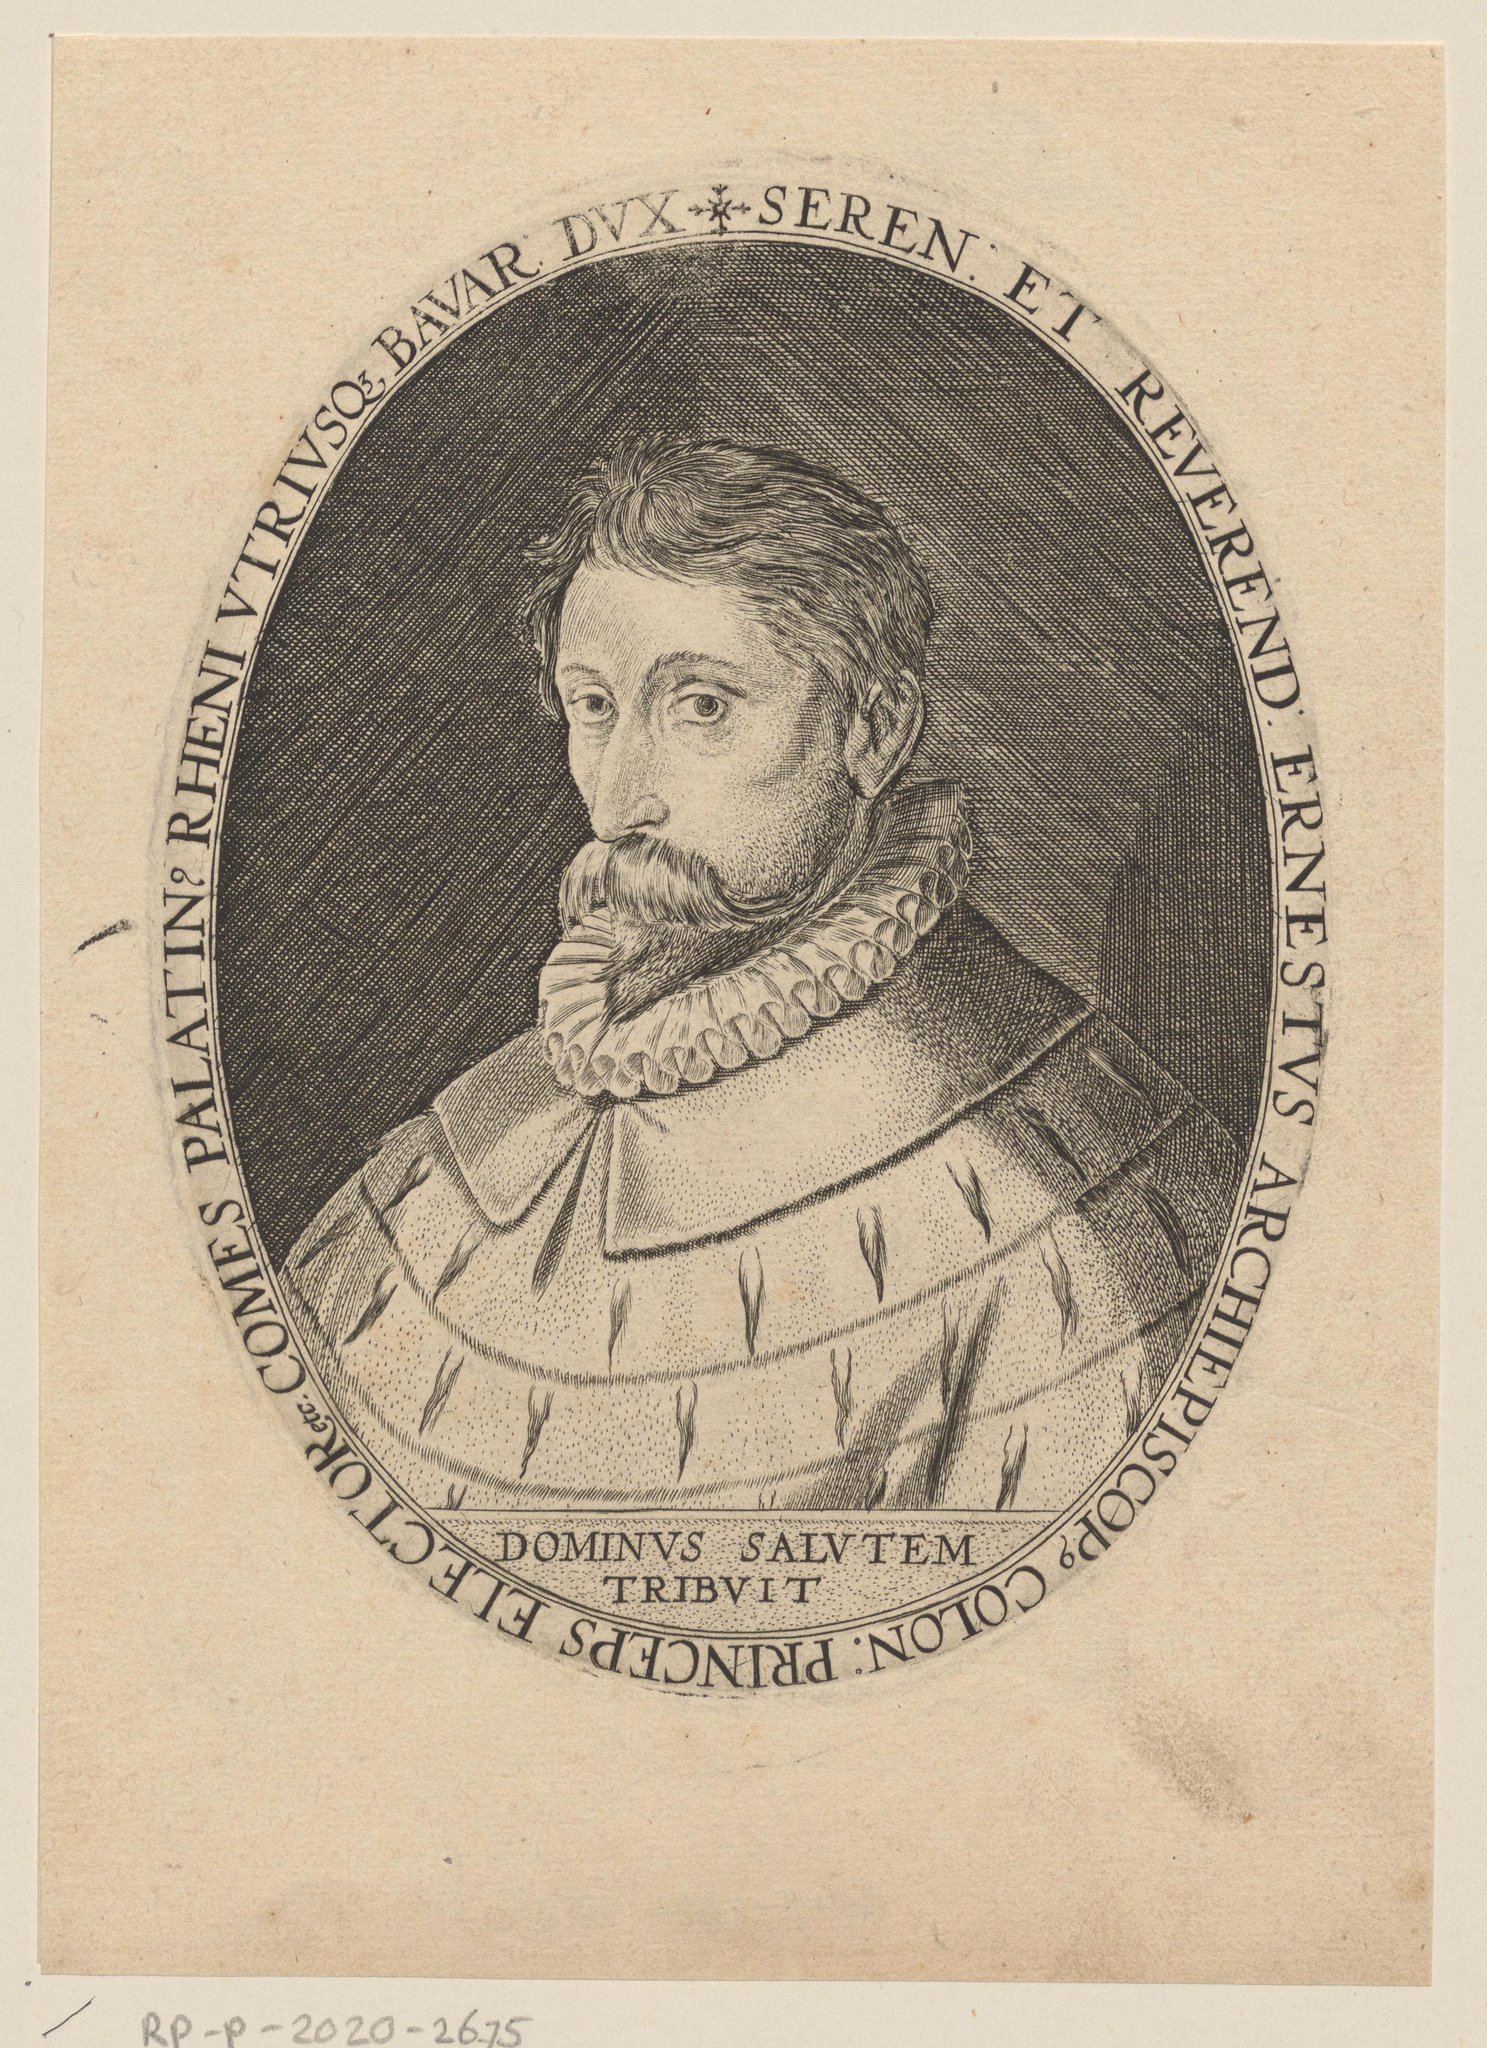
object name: print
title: Portret van Ernst van Beieren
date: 1590-1599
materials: paper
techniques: engraving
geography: low countries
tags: ernst van beieren (prins-bisschop van luik), historical persons